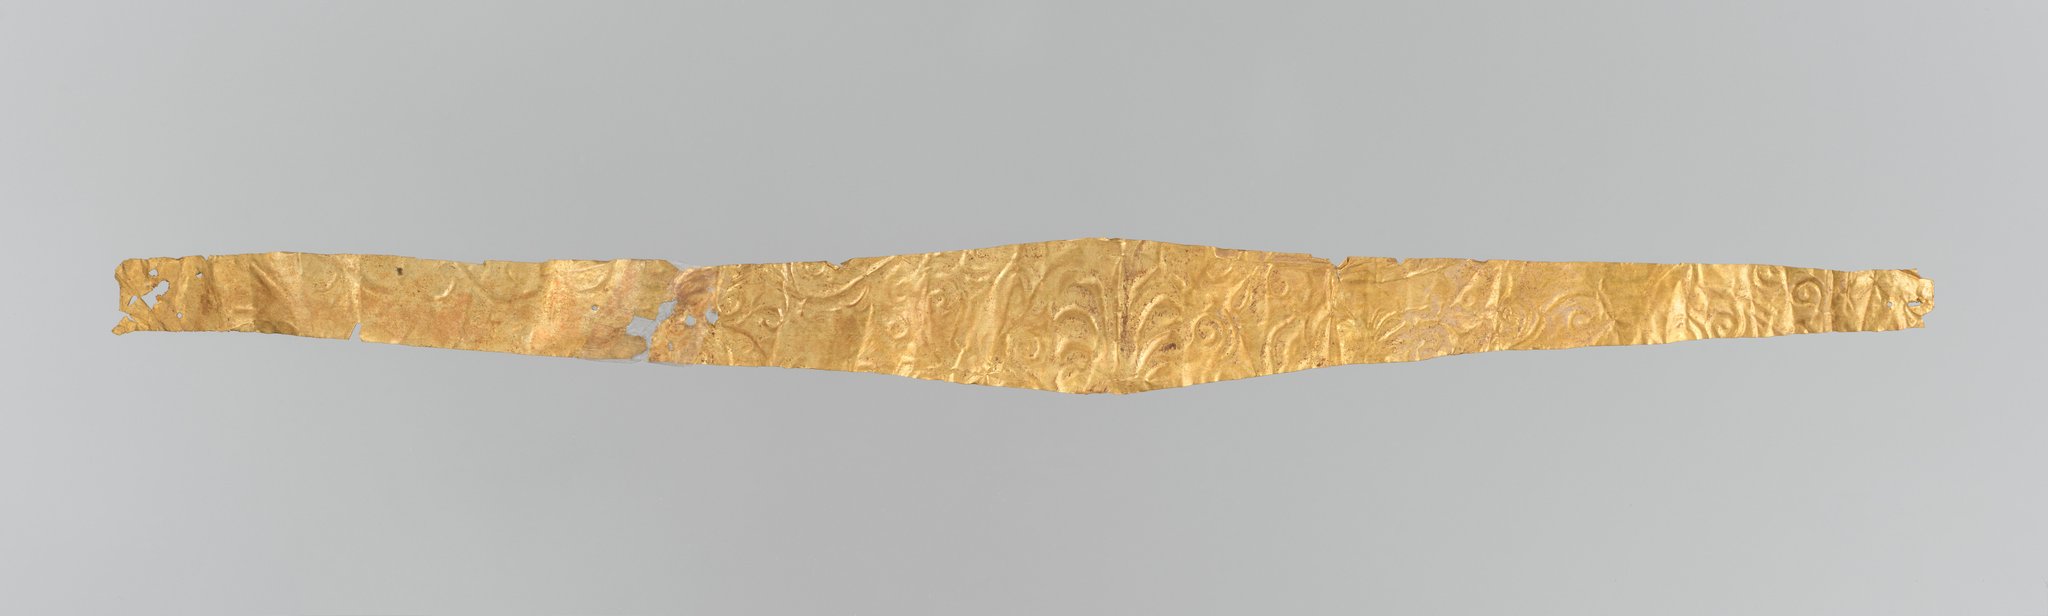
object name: frontlet of gold leaf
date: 7000 BCE-330 CE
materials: gold